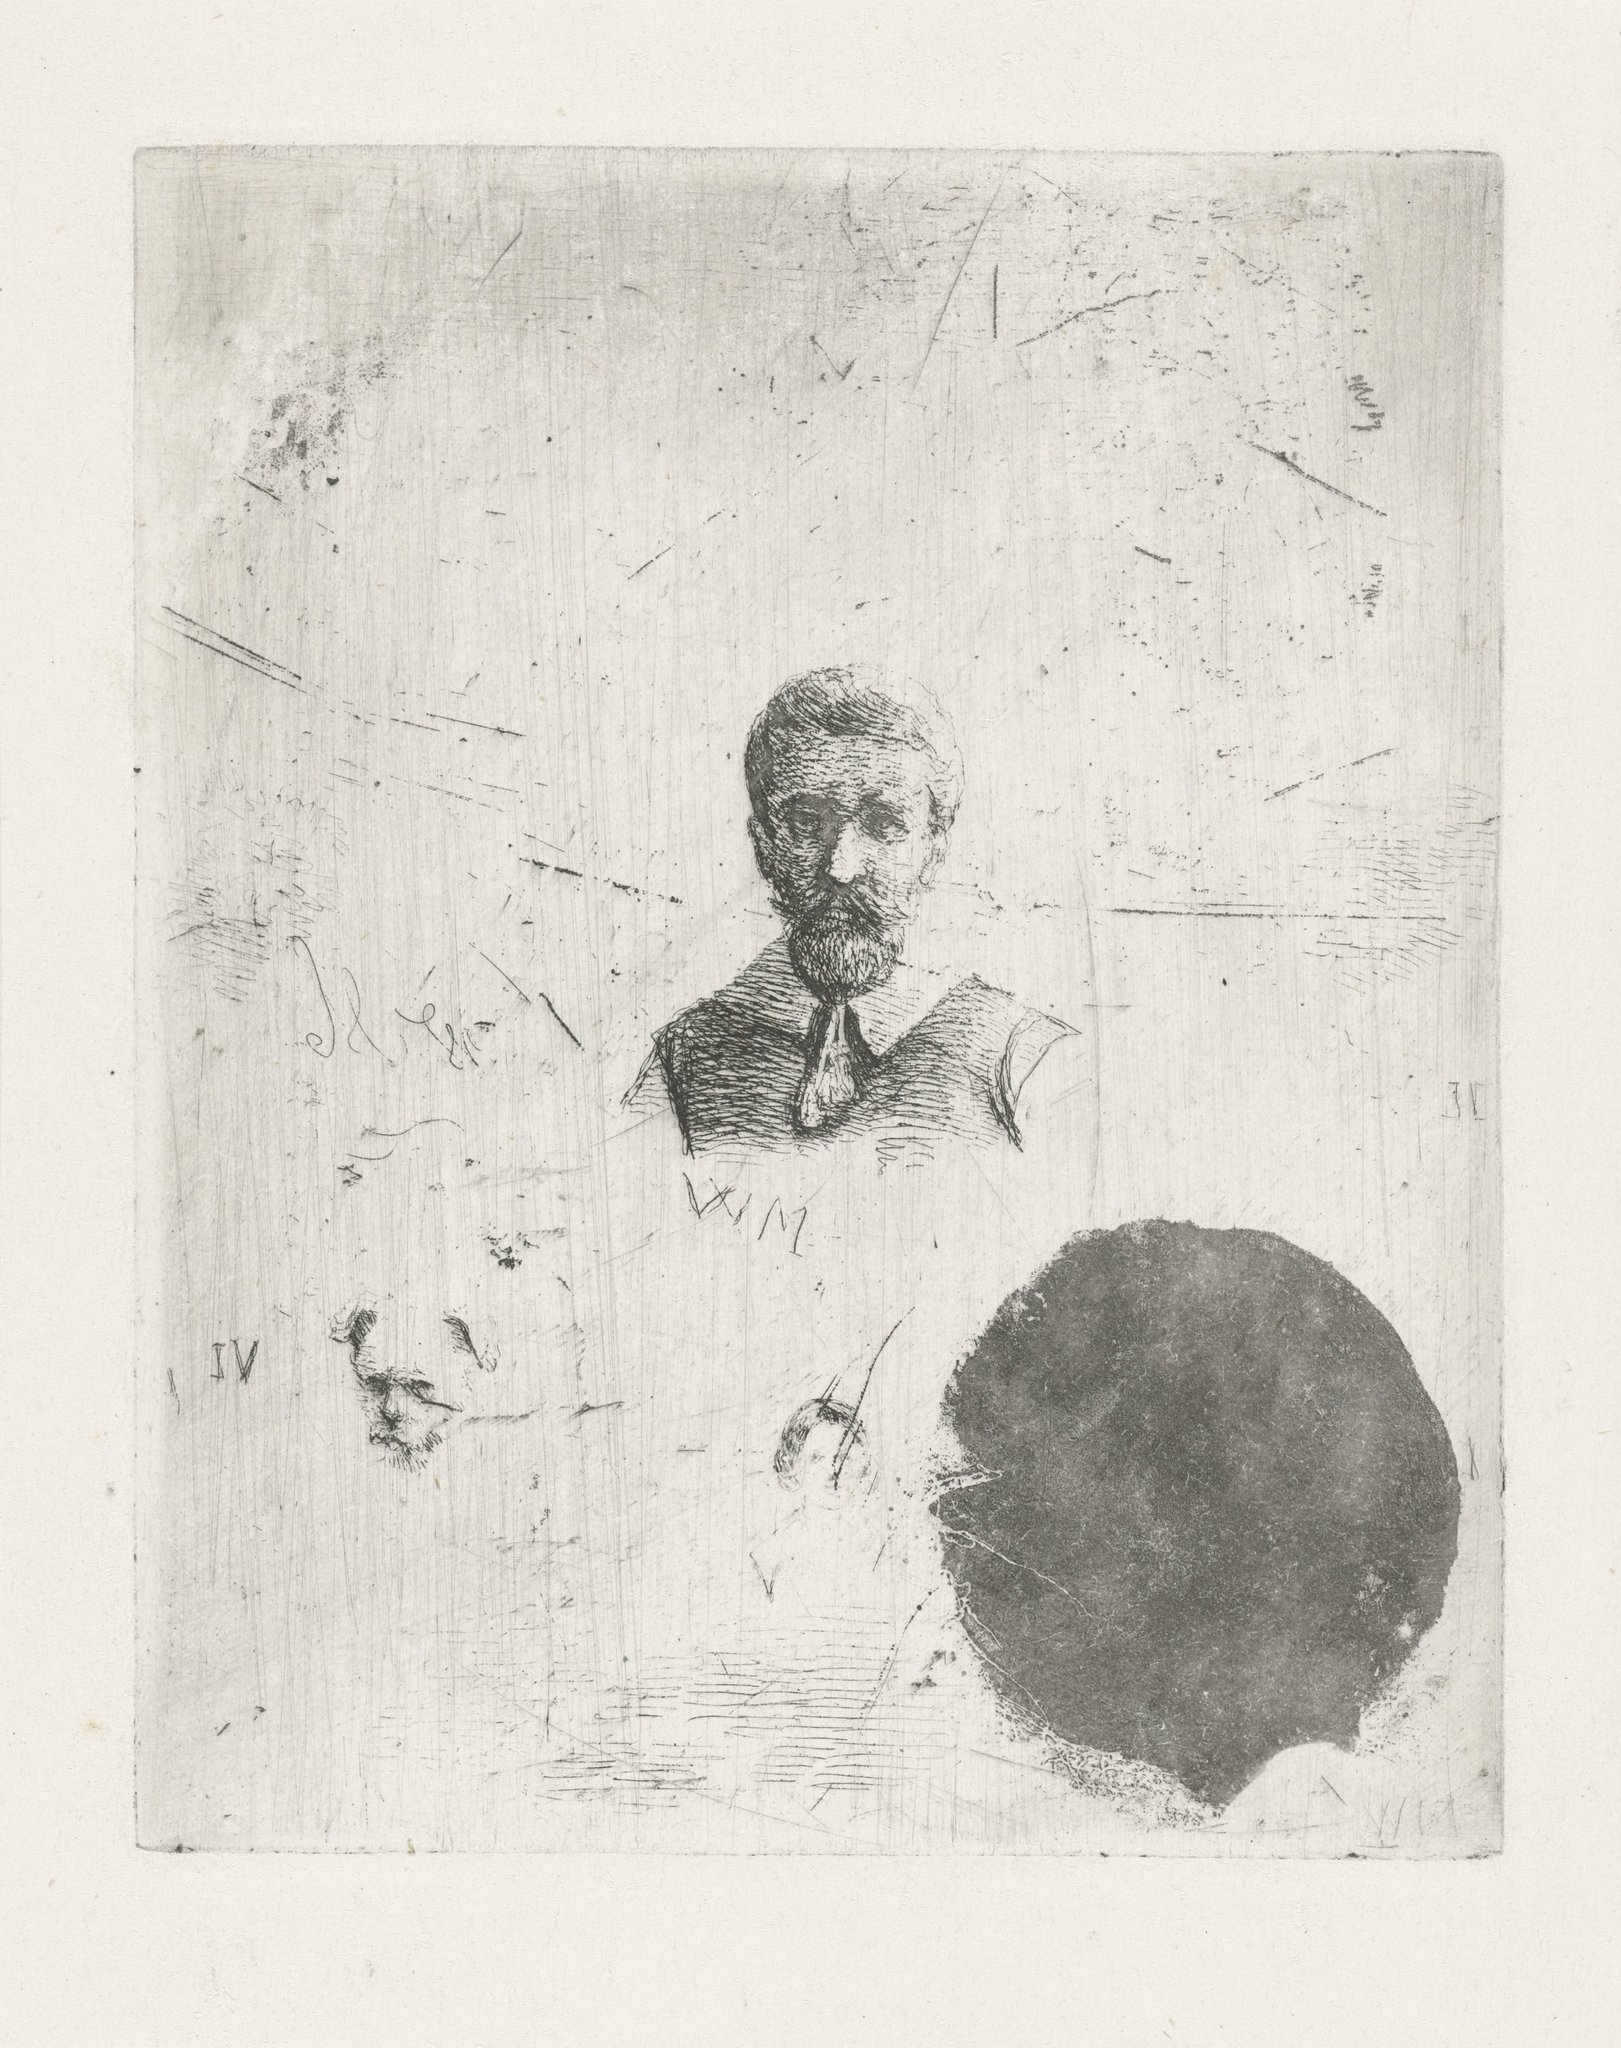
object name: print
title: Studieblad met de buste van een man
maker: christiaan wilhelmus moorrees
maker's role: draughtsman, print maker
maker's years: 1801-1867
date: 1811-1867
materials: paper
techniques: etching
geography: netherlands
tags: head (human)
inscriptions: collector's mark: Lugt 2228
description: Studieblad met in het midden de buste van een man met baard. Links de kop van en hond.